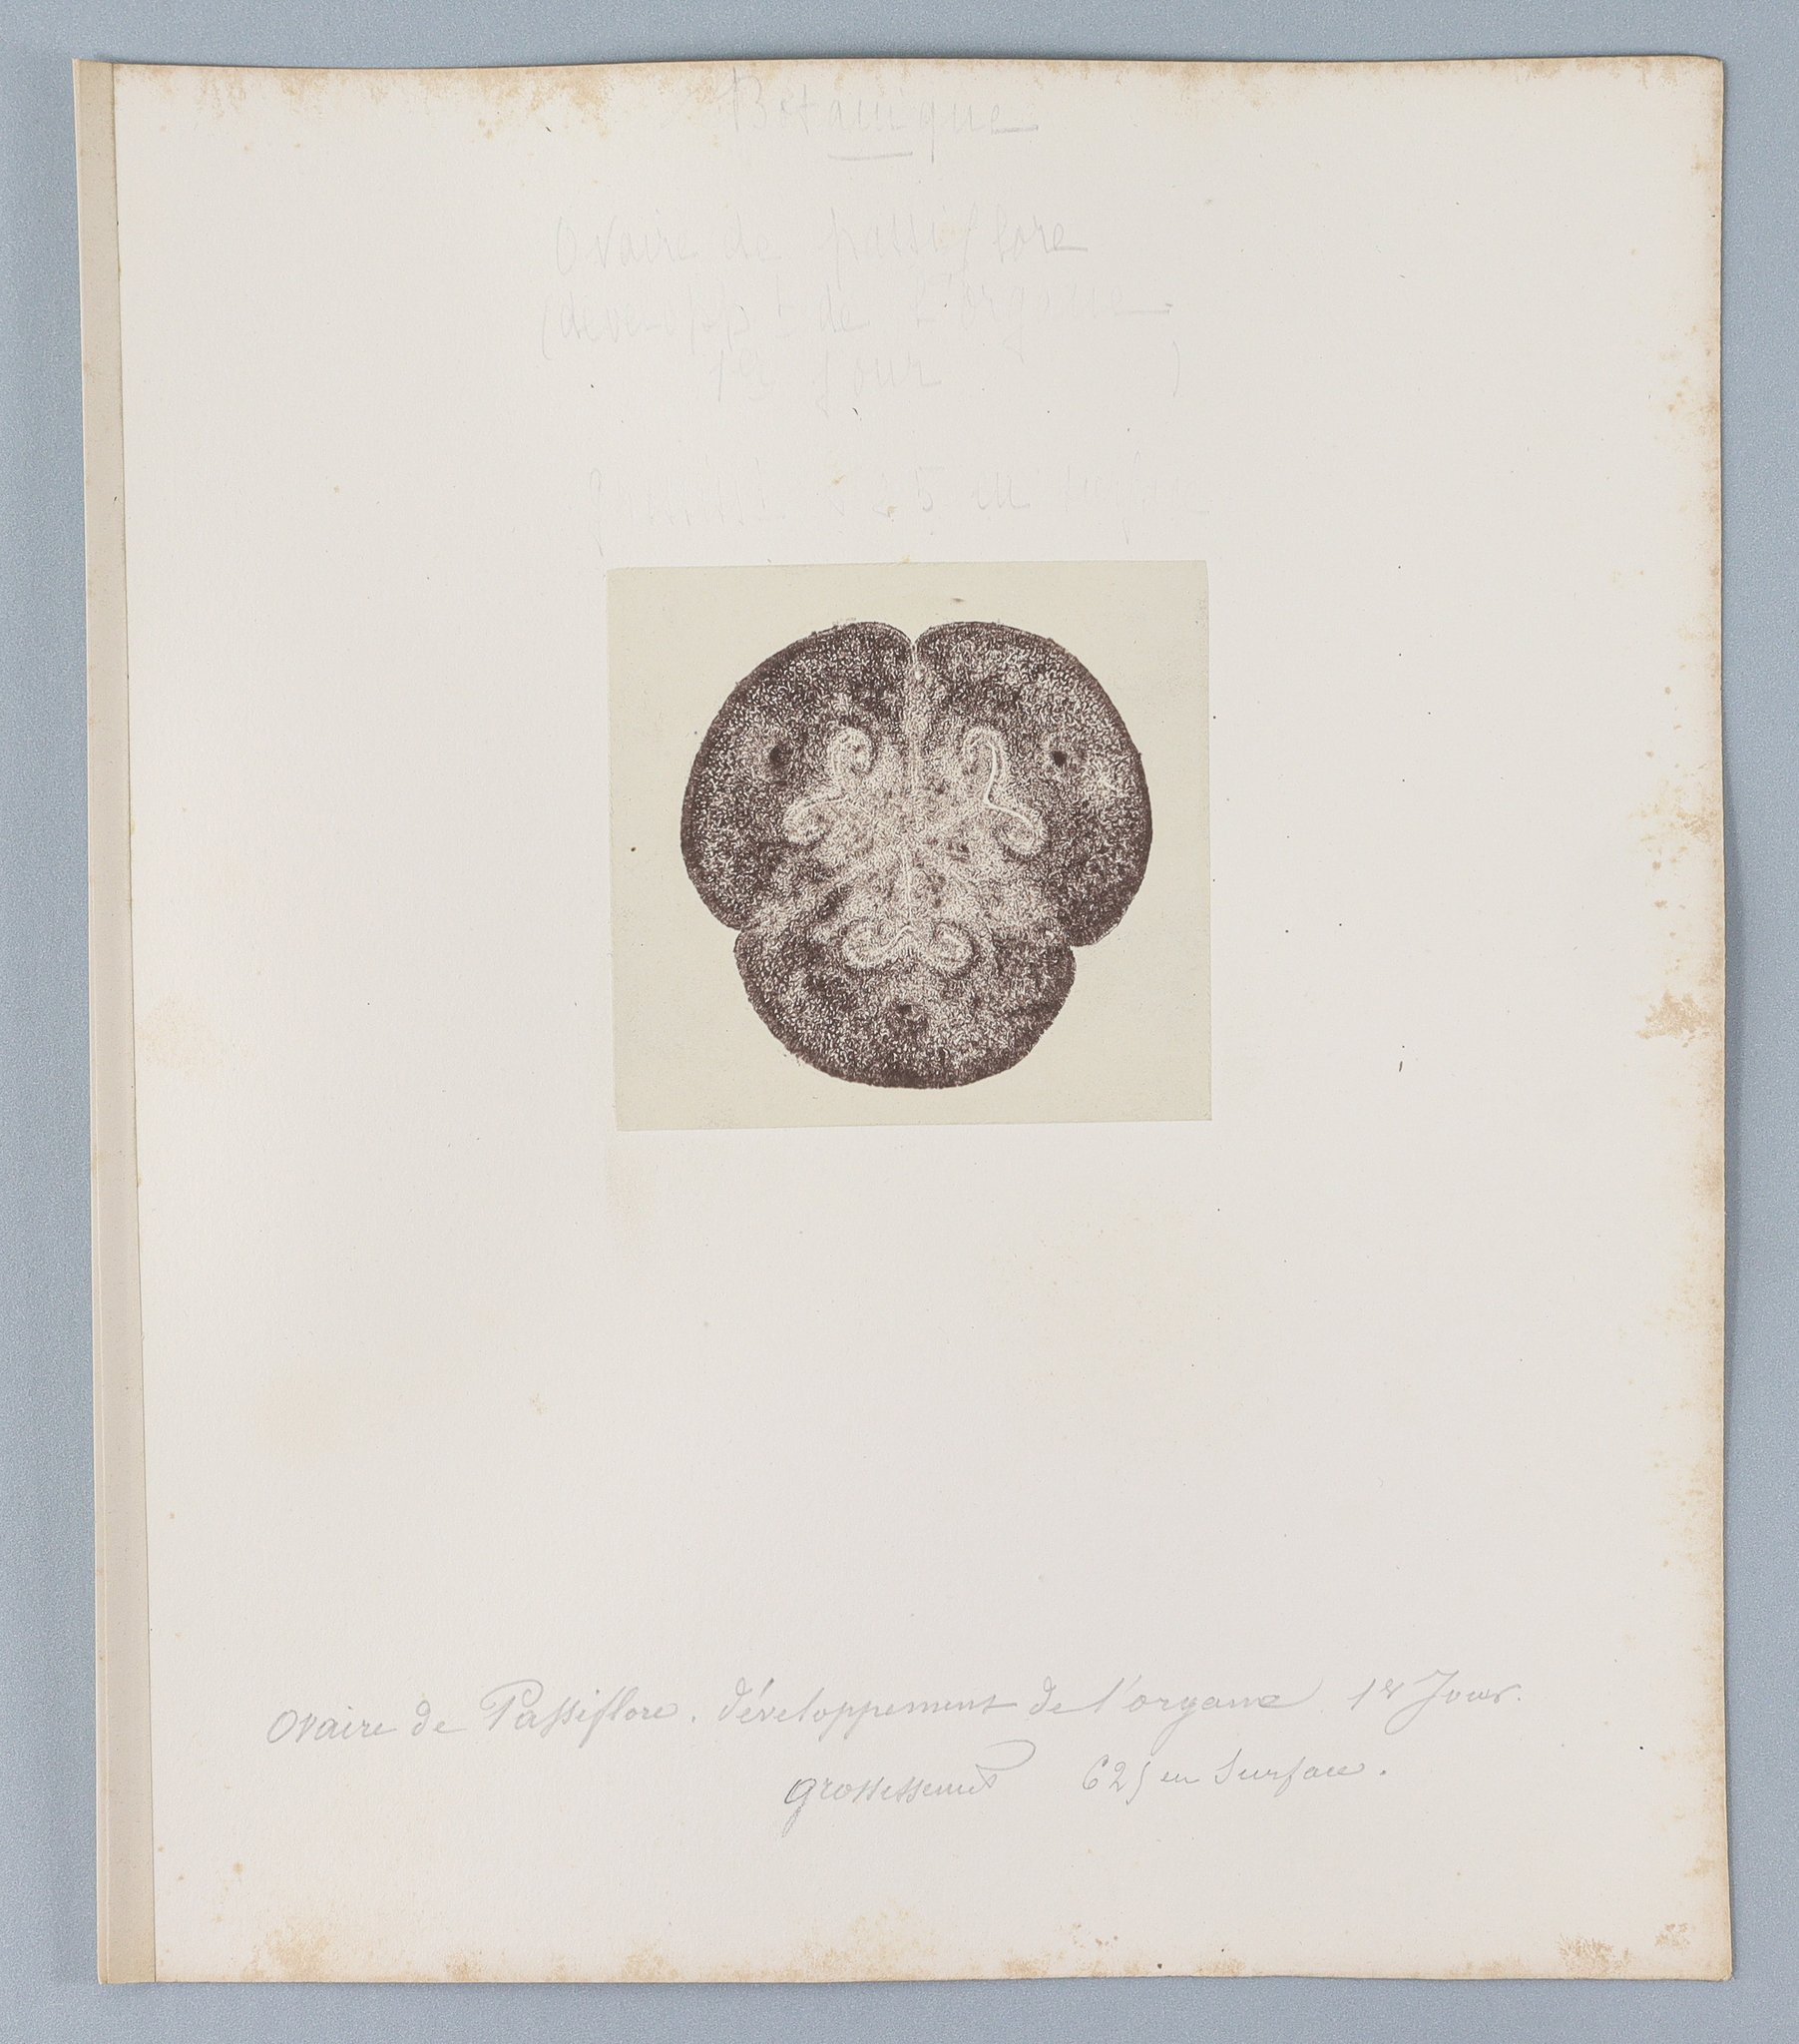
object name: photograph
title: [Untitled]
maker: auguste-adolphe bertsch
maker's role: artist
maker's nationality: french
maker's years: 1813-1871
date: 1853-1857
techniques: salted paper print